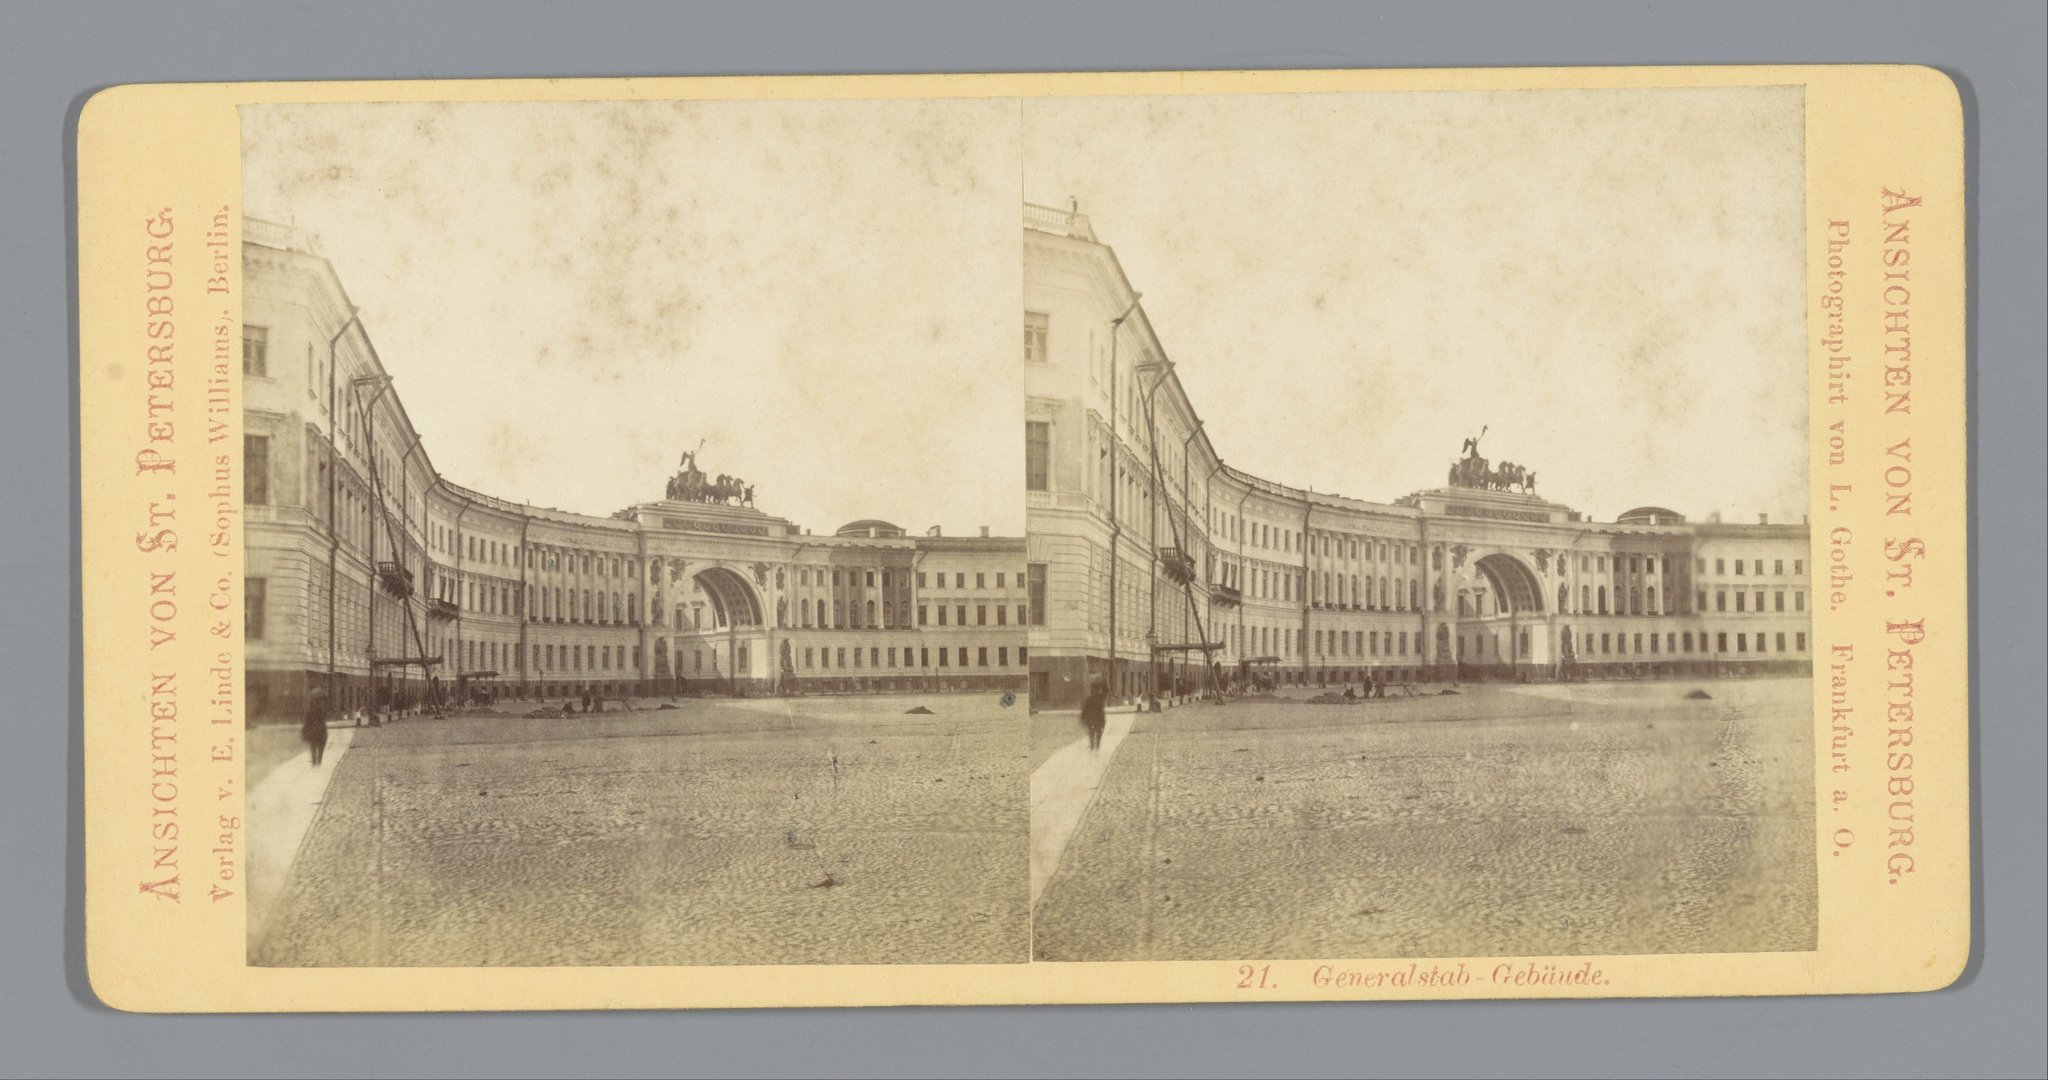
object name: stereograph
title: Generalstab-Gebäude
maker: louis gothe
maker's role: fotograaf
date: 1850-1880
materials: cardboard, photographic support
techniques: albumen print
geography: sint-petersburg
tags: triumphal arch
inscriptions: inscription: ‘Ansichten von St. Petersburg.’, number: ‘21.’